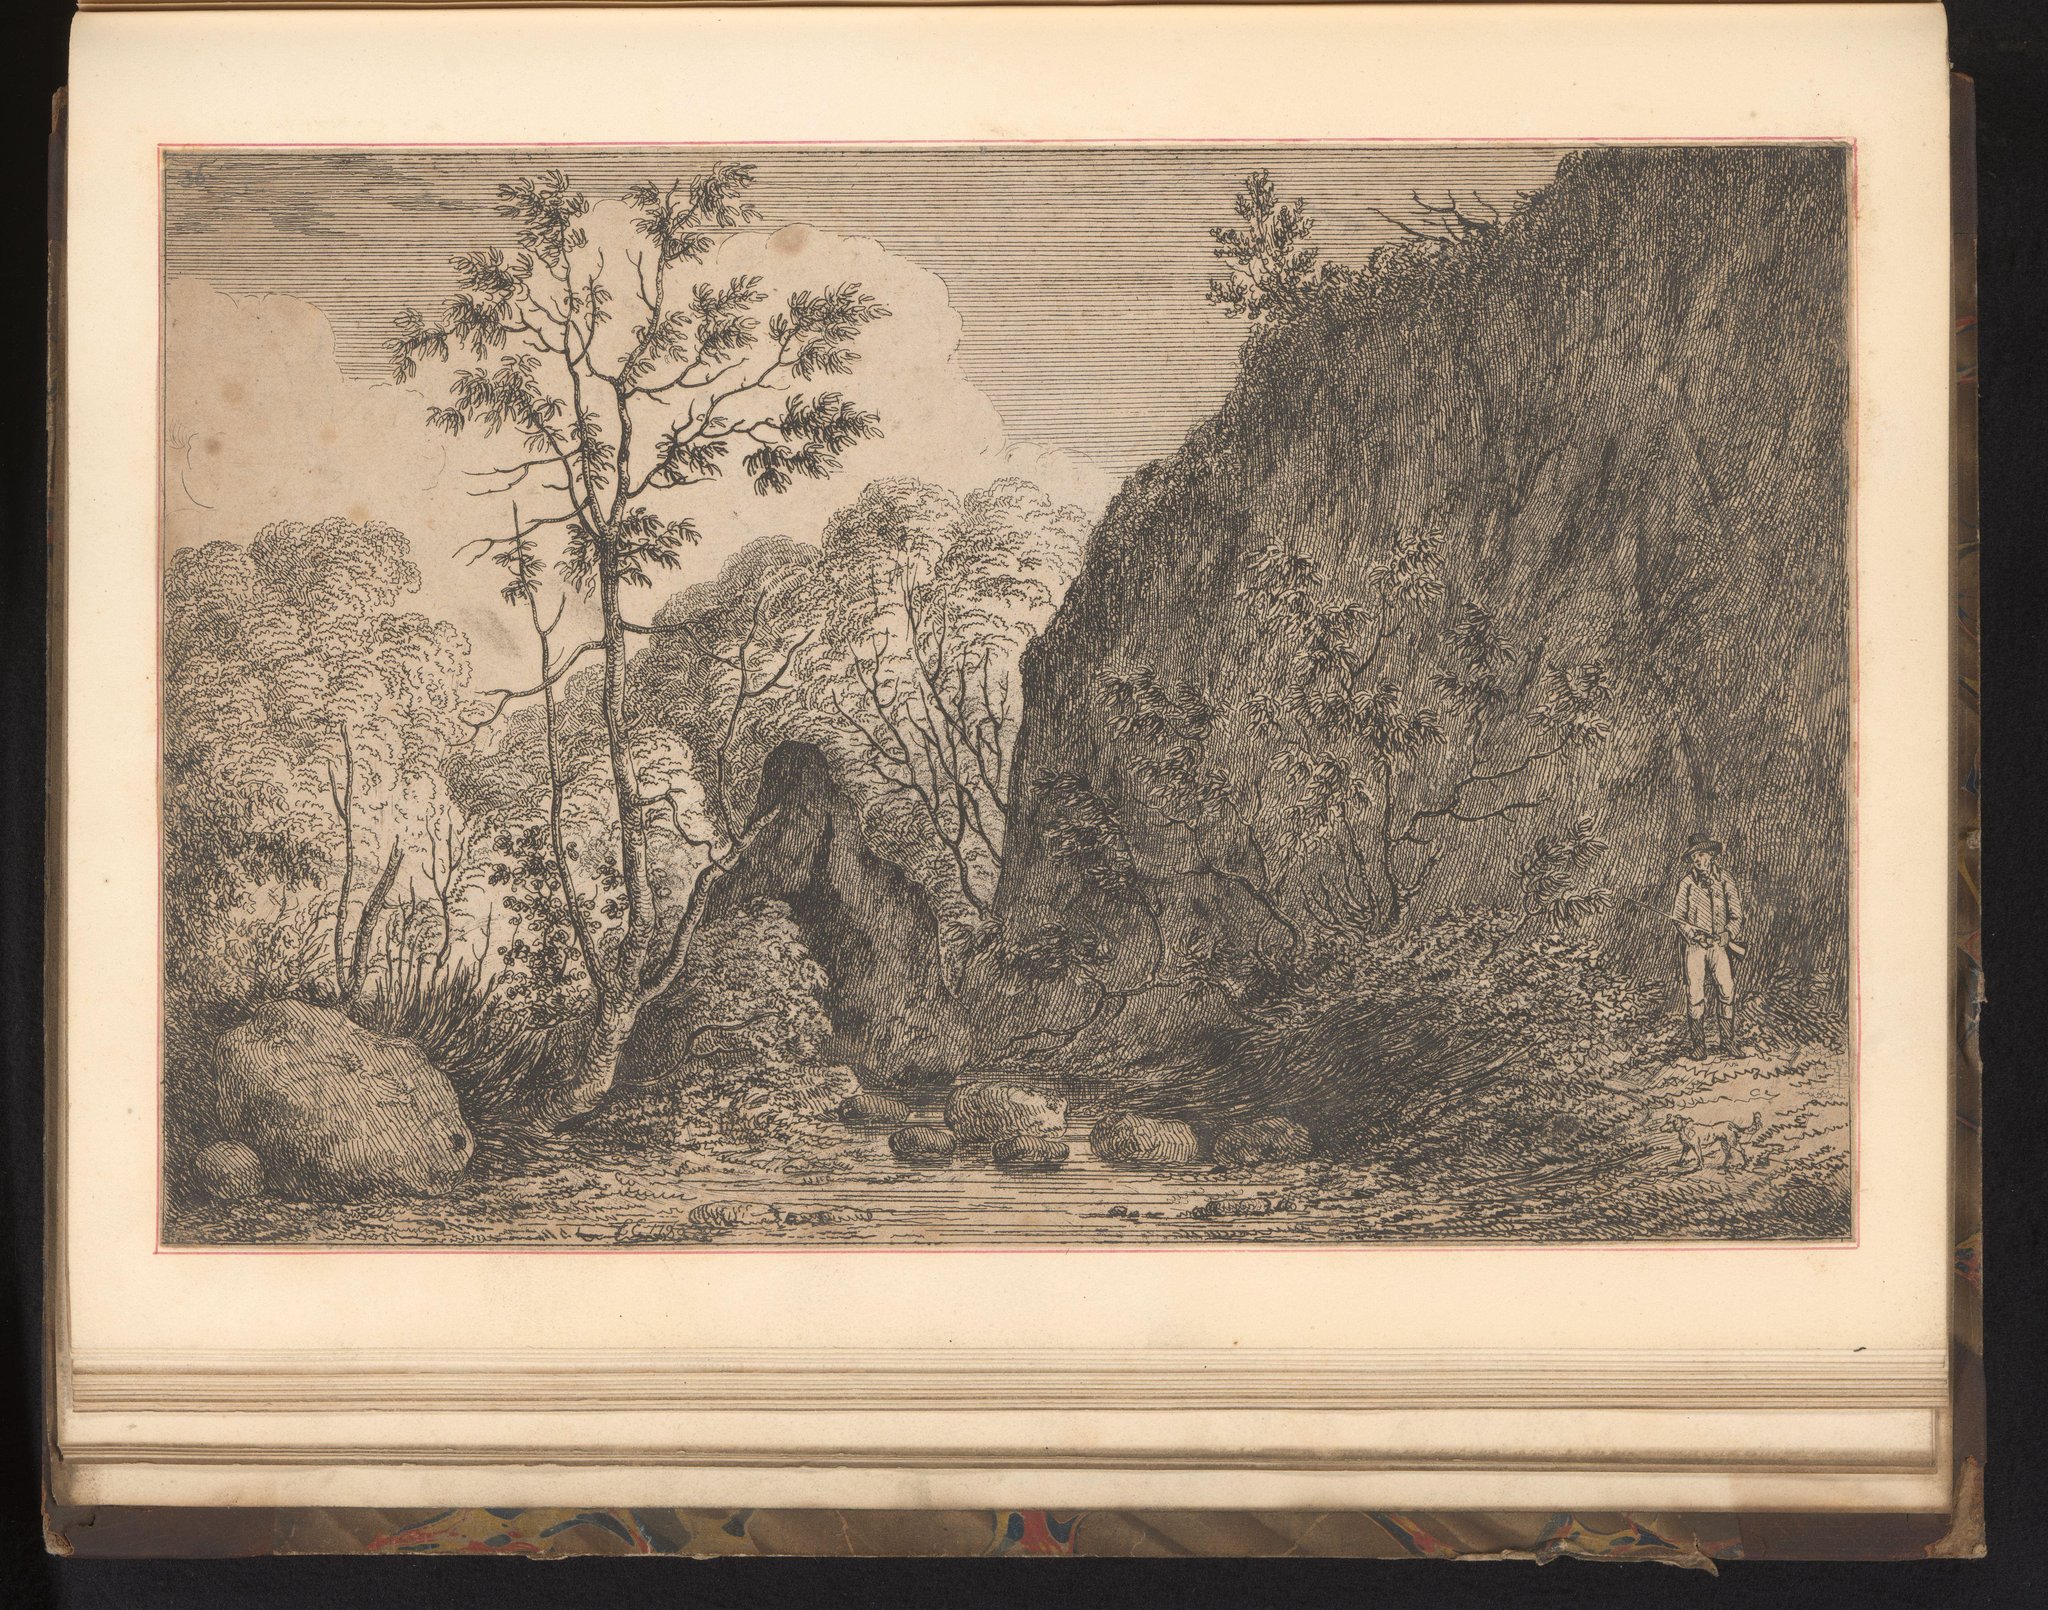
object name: album leaf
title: Landschap met een jager bij rotsen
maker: edward edwards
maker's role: painter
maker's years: 1738-1806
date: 1789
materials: paper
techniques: etching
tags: hunter, rock-formations, landscapes (+ landscape with figures, staffage)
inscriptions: number: ‘36’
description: Prent maakt deel uit van een serie van 51 prenten, bestaande uit twee delen met landschappen (36 prenten) en figuren en portretten (15 prenten), voor het eerst uitgegeven in Londen in 1790.